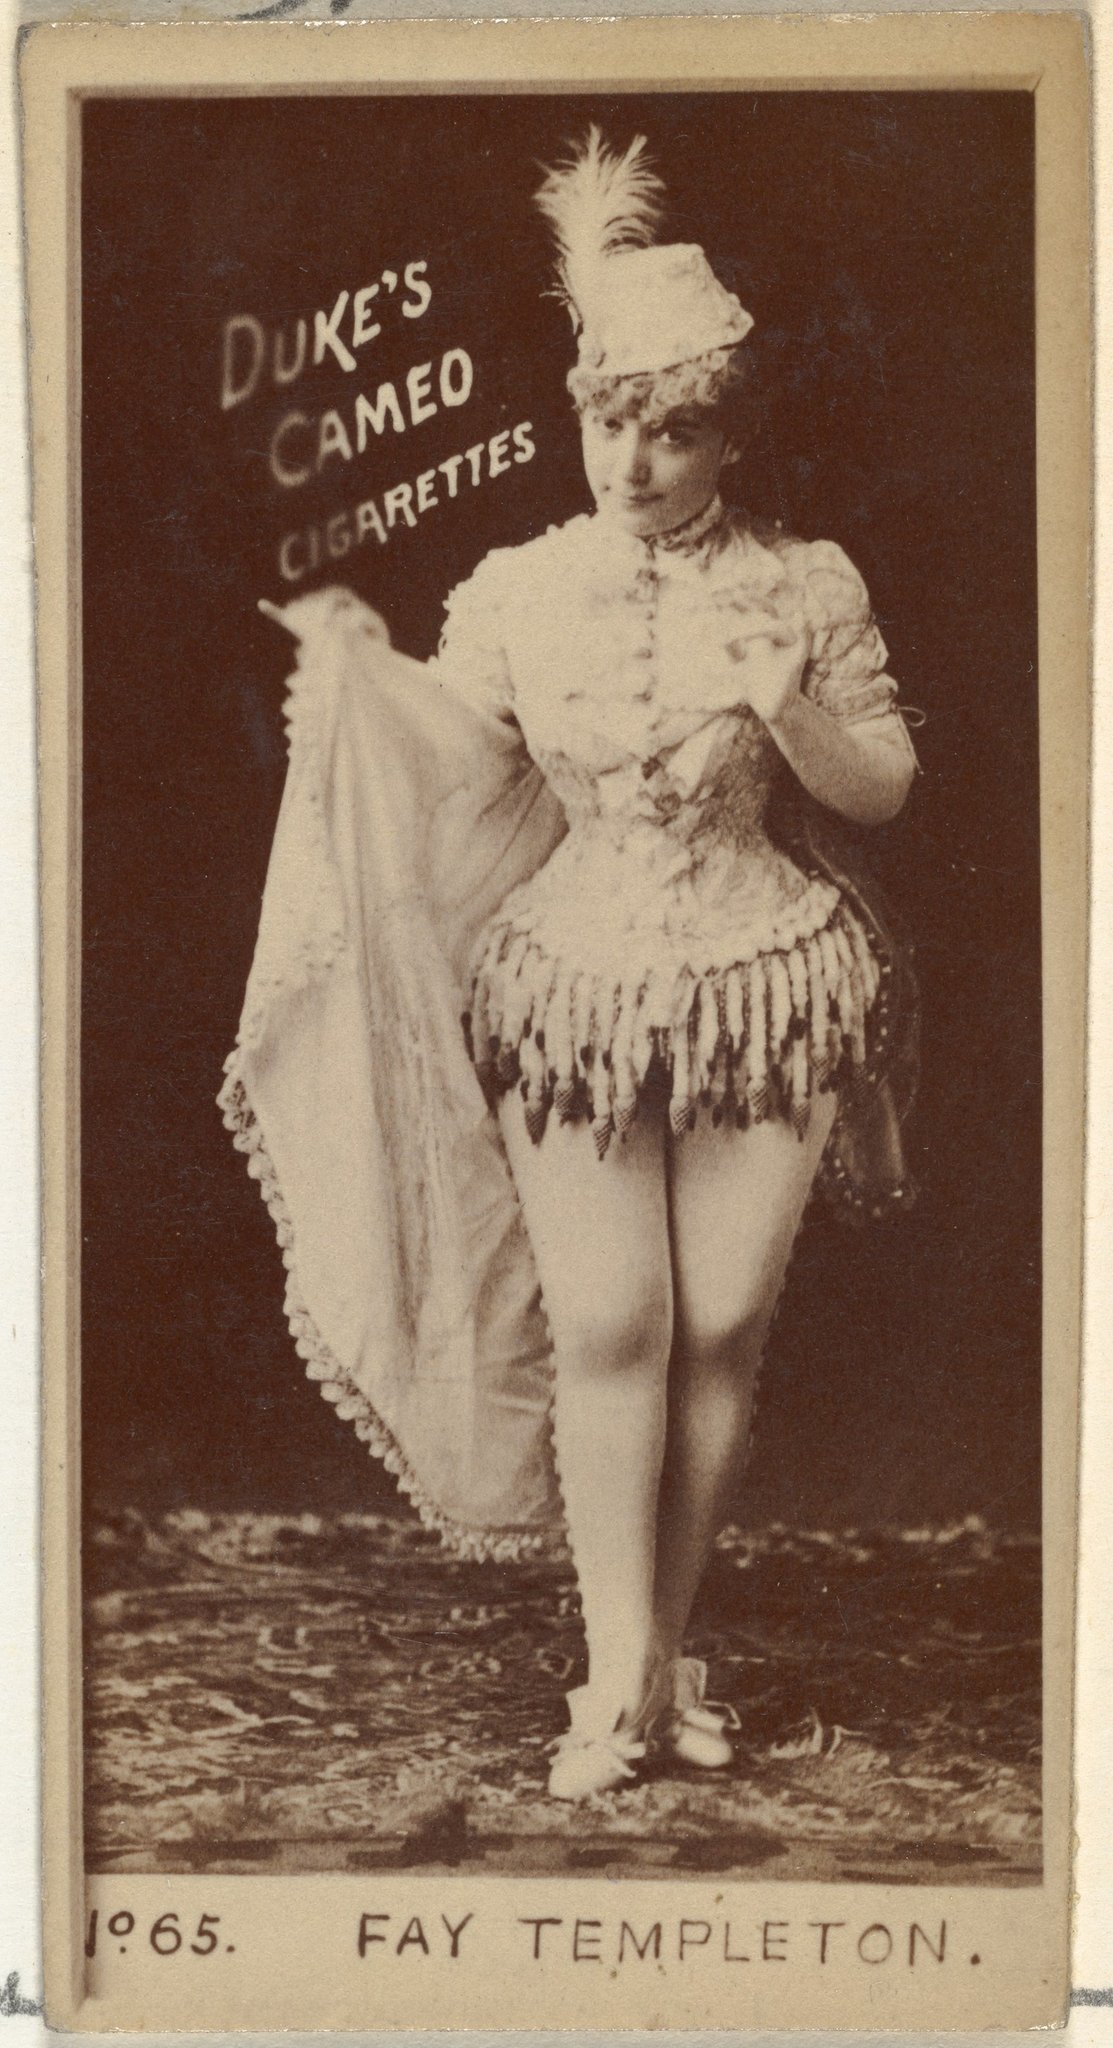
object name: photograph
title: Card Number 65, Fay Templeton, from the Actors and Actresses series (N145-4) issued by Duke Sons & Co. to promote Cameo Cigarettes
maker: w. duke, sons & co.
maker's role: publisher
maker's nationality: american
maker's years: 1870-1920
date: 1880-1889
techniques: albumen silver print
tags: portraits,women,actresses